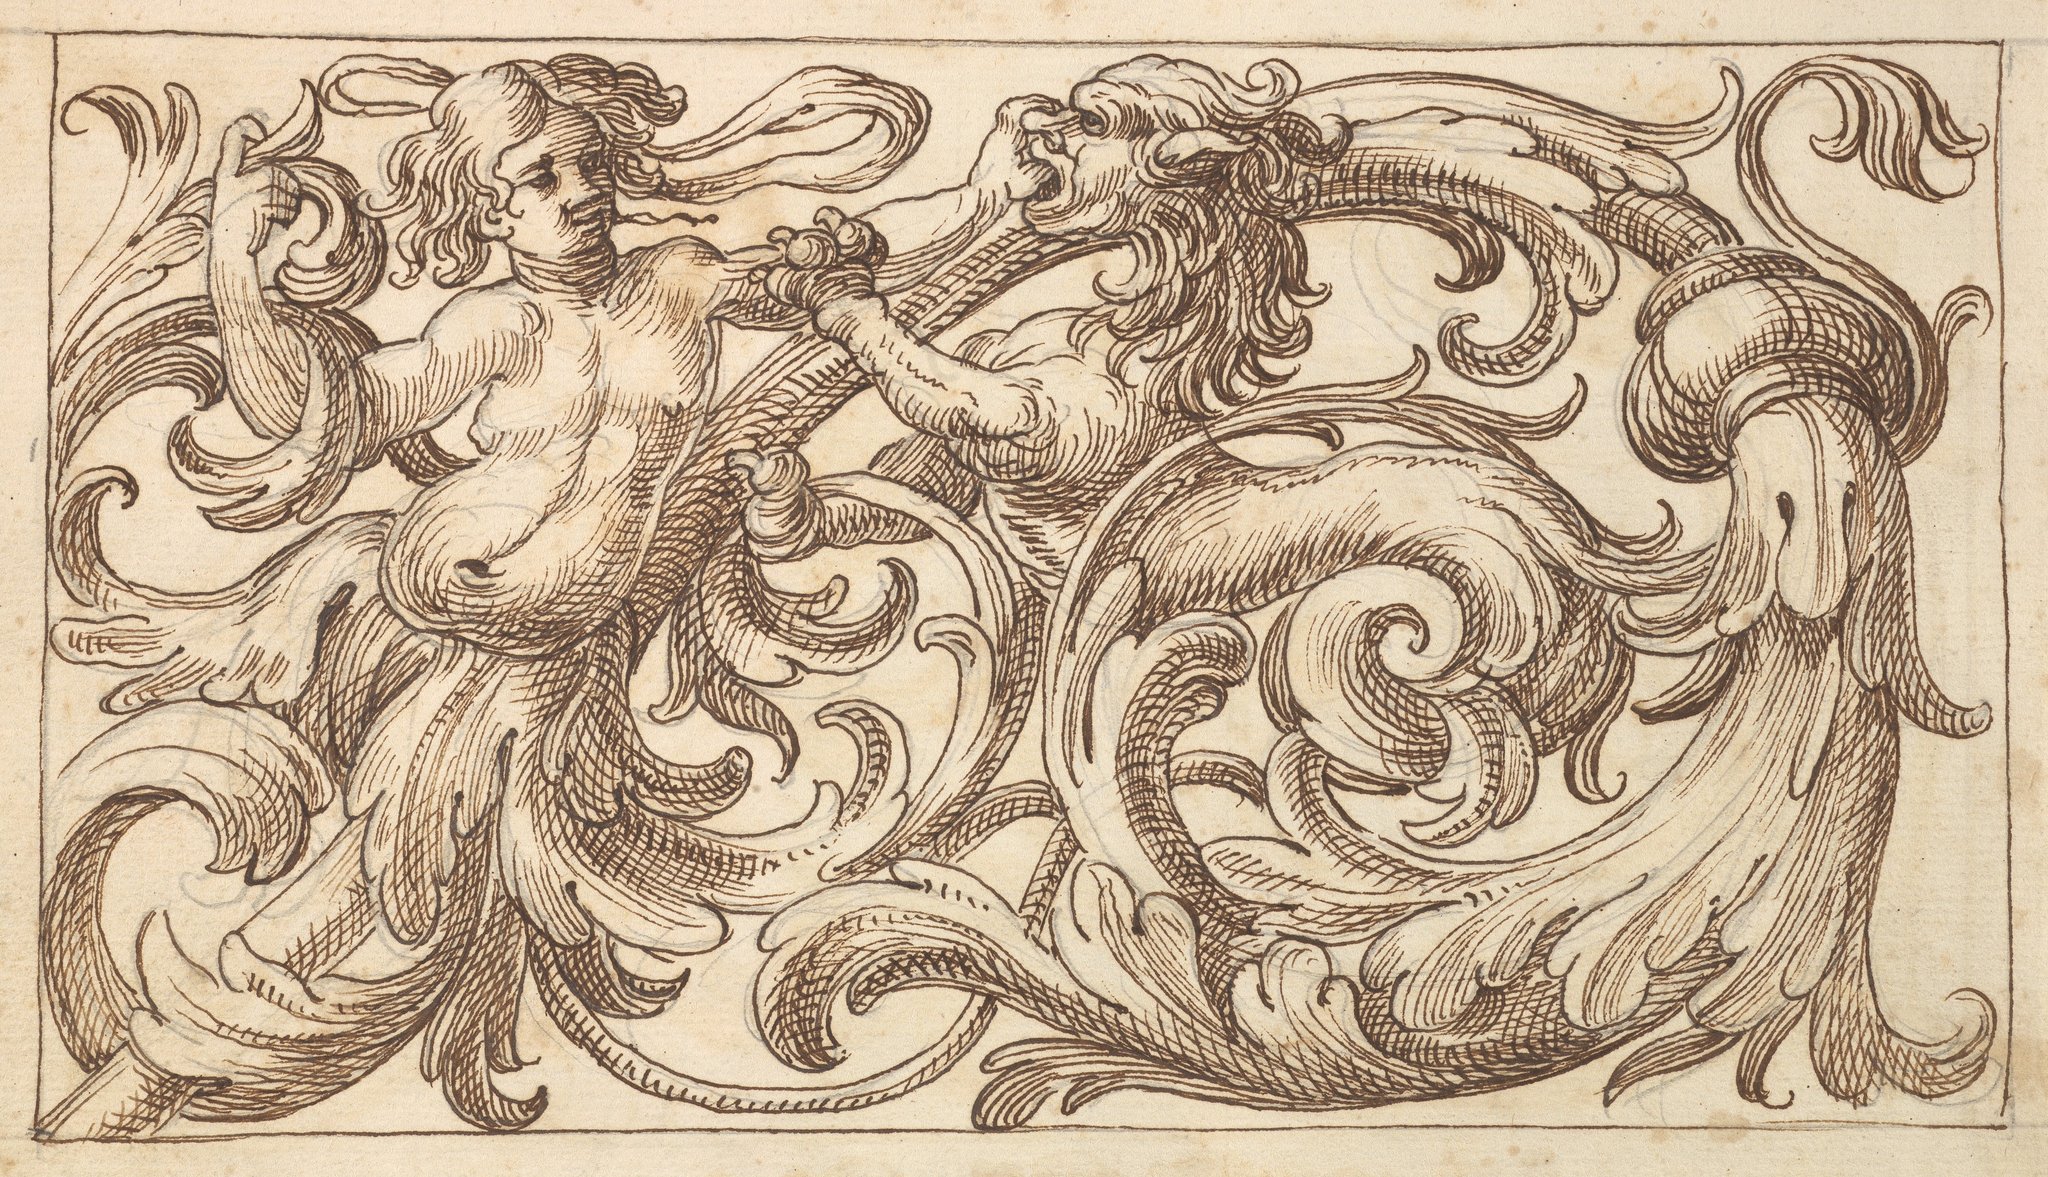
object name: collection ornament architecture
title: Horizontal Panel Design with a Young Man and a (male) Sphinx Interspersed between Acanthus Rinceaux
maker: anonymous, italian, venetian, 17th century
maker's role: artist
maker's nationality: italian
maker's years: 1600-1700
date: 1601-1700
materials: ink, drawing material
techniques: pen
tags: men,sphinx,acanthus